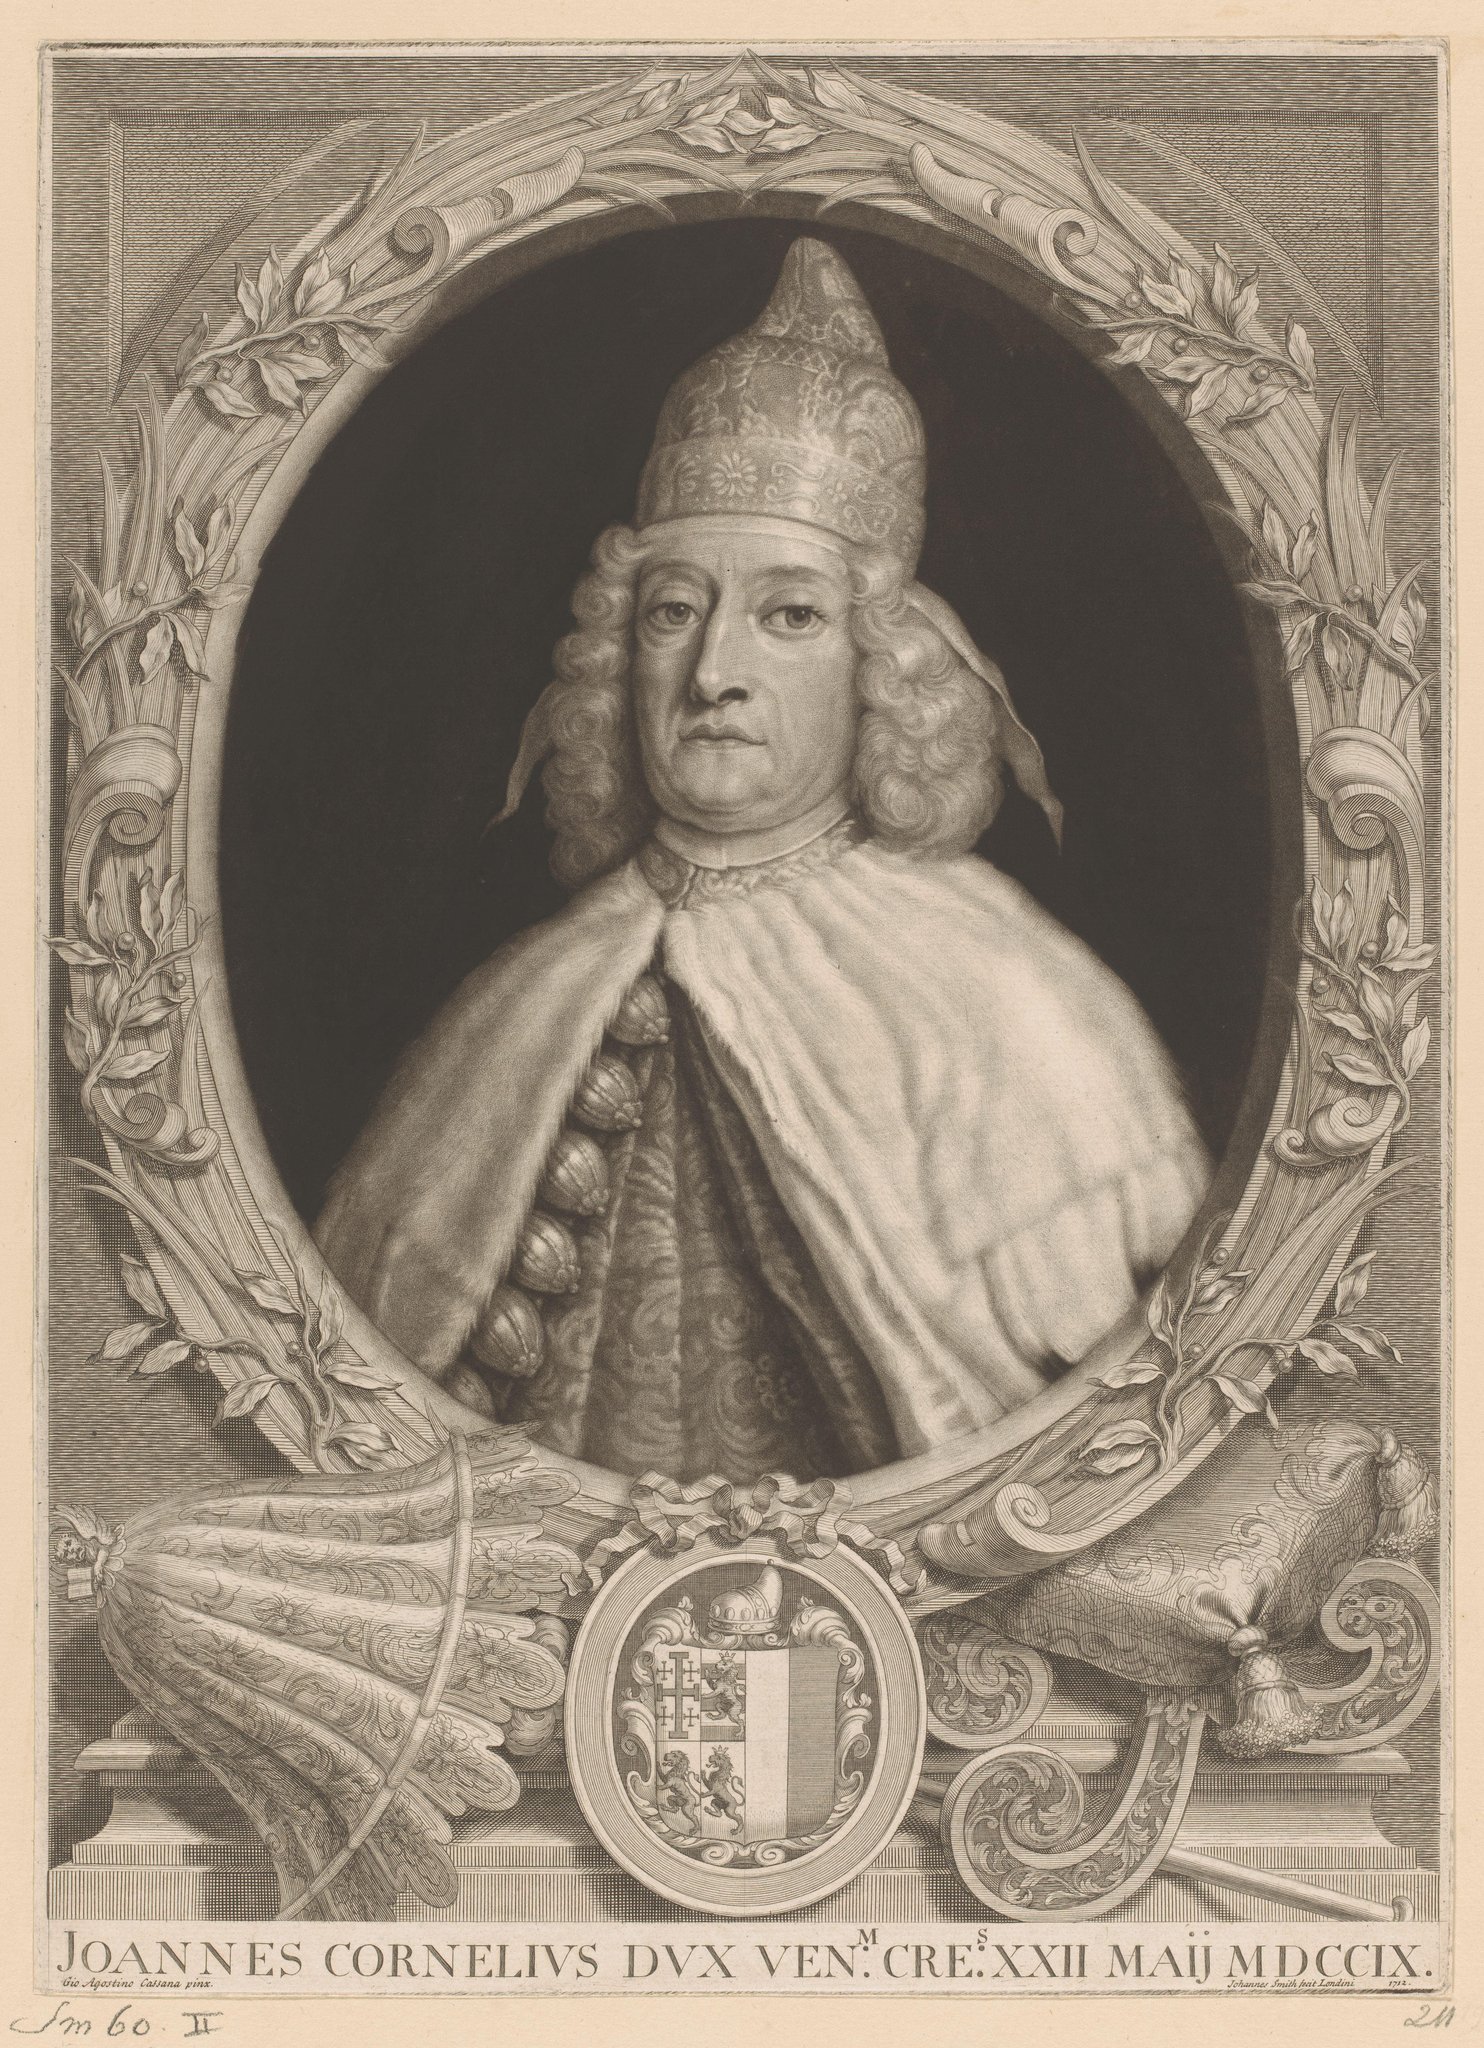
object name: print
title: Portret van Giovanni Cornaro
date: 1712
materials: paper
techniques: engraving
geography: london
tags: venice, politician, historical persons, other sovereign: doge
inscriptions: collector's mark: Lugt 240